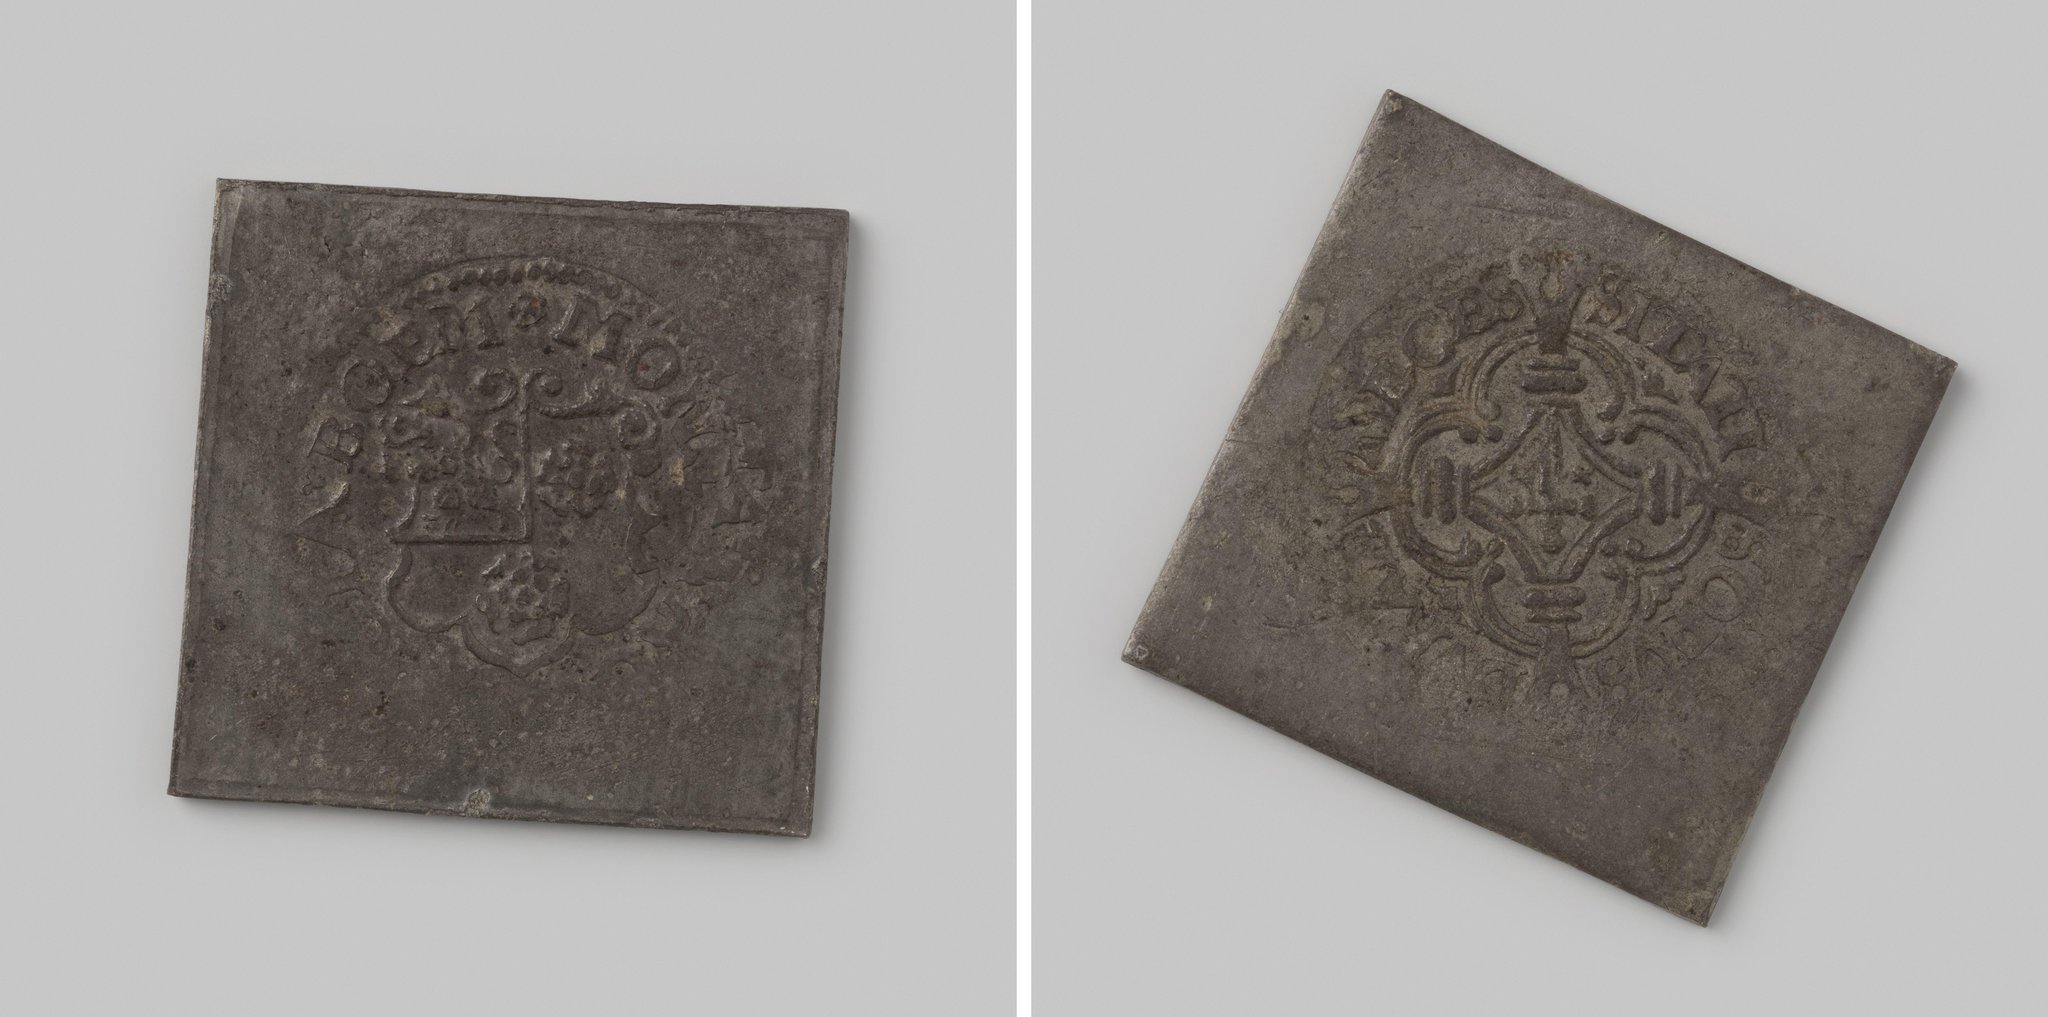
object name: coin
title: Afslag in tin van een stuiver van de stad Zaltbommel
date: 1579-1582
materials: tin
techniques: striking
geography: zaltbommel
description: Tinnen afslag van een zilveren munt. Voorzijde: wapenschild van de stad. Omschrift: rozet MONETA NOVA FACTA BOEM. Keerzijde: vierpas, waarop lang gelelied kruis met in het midden een omhoog stekend zwaard met aan weerzijden daarvan een rozet. Linksonder beginnend omschrift: DVRAE-NECES-SITATI-S OPVS. Afslag in tin op vierkant muntplaatje.